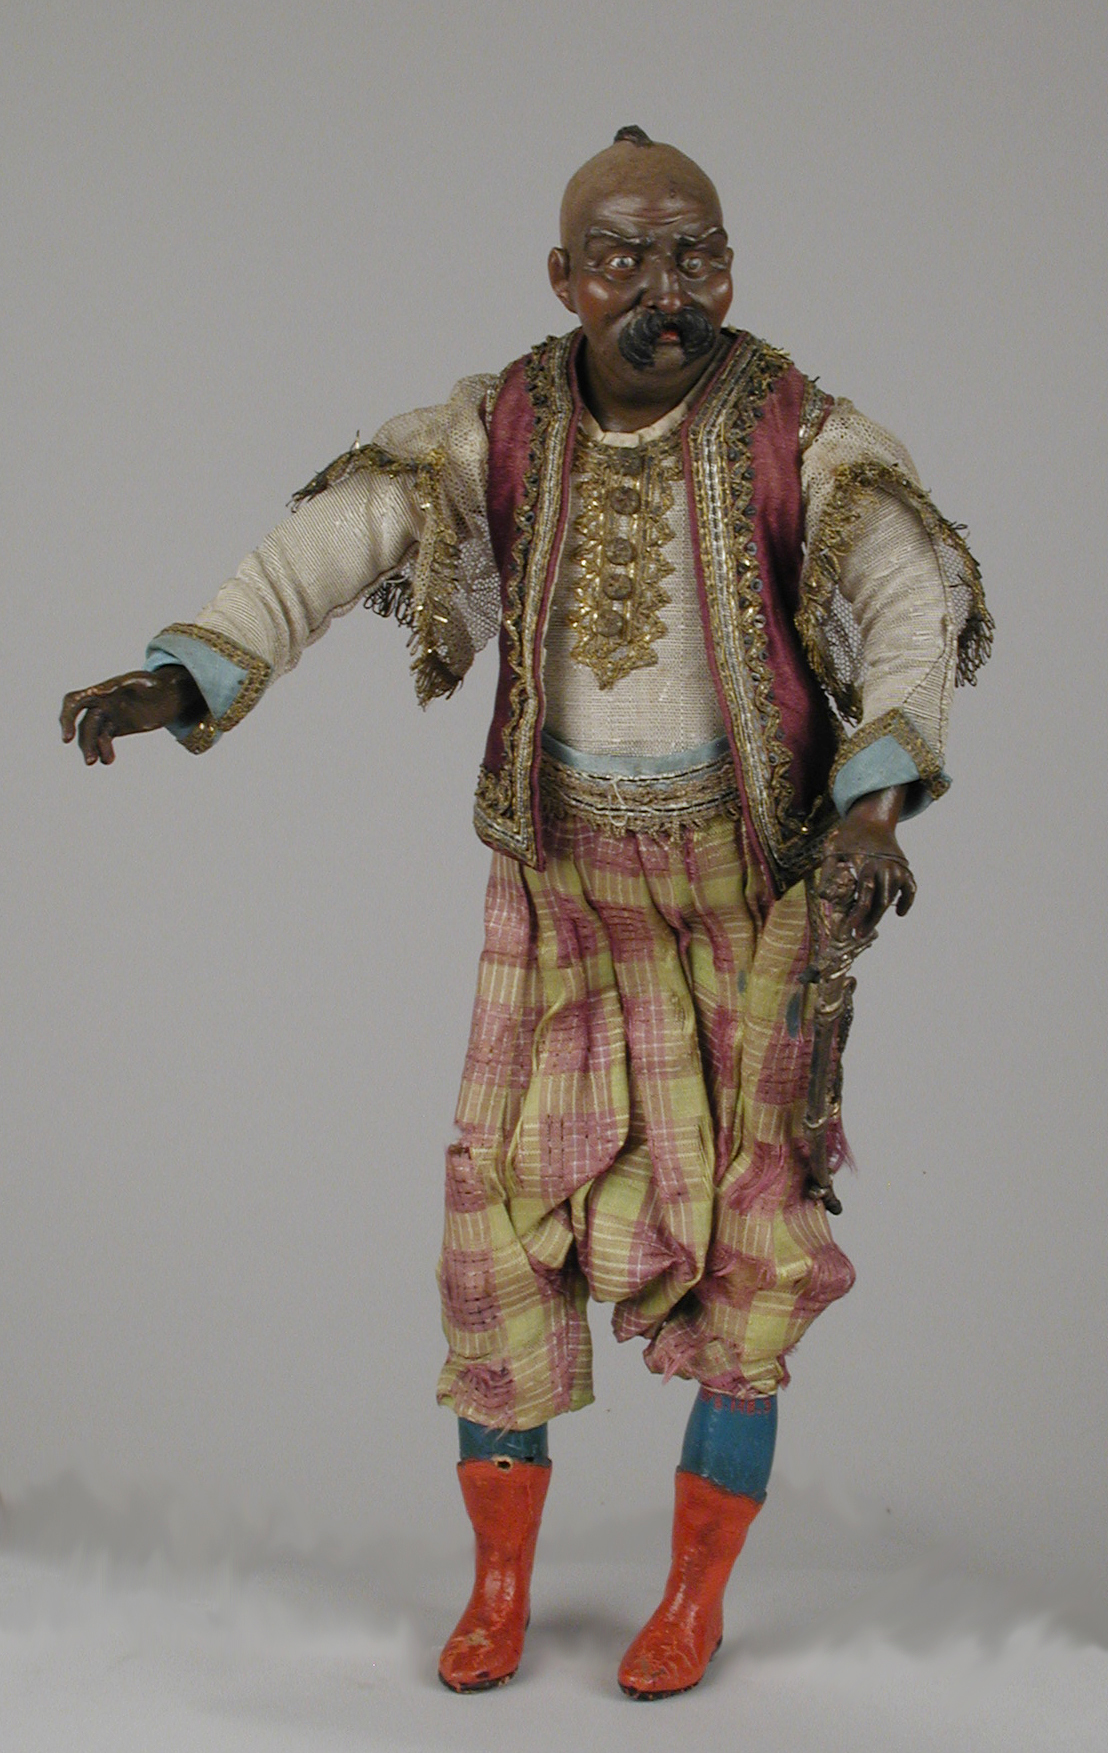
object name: crèche figure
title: King's attendant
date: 1767-1833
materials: gilt, gold thread, metal, silk, silver, terracotta, fiber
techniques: polychrome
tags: men